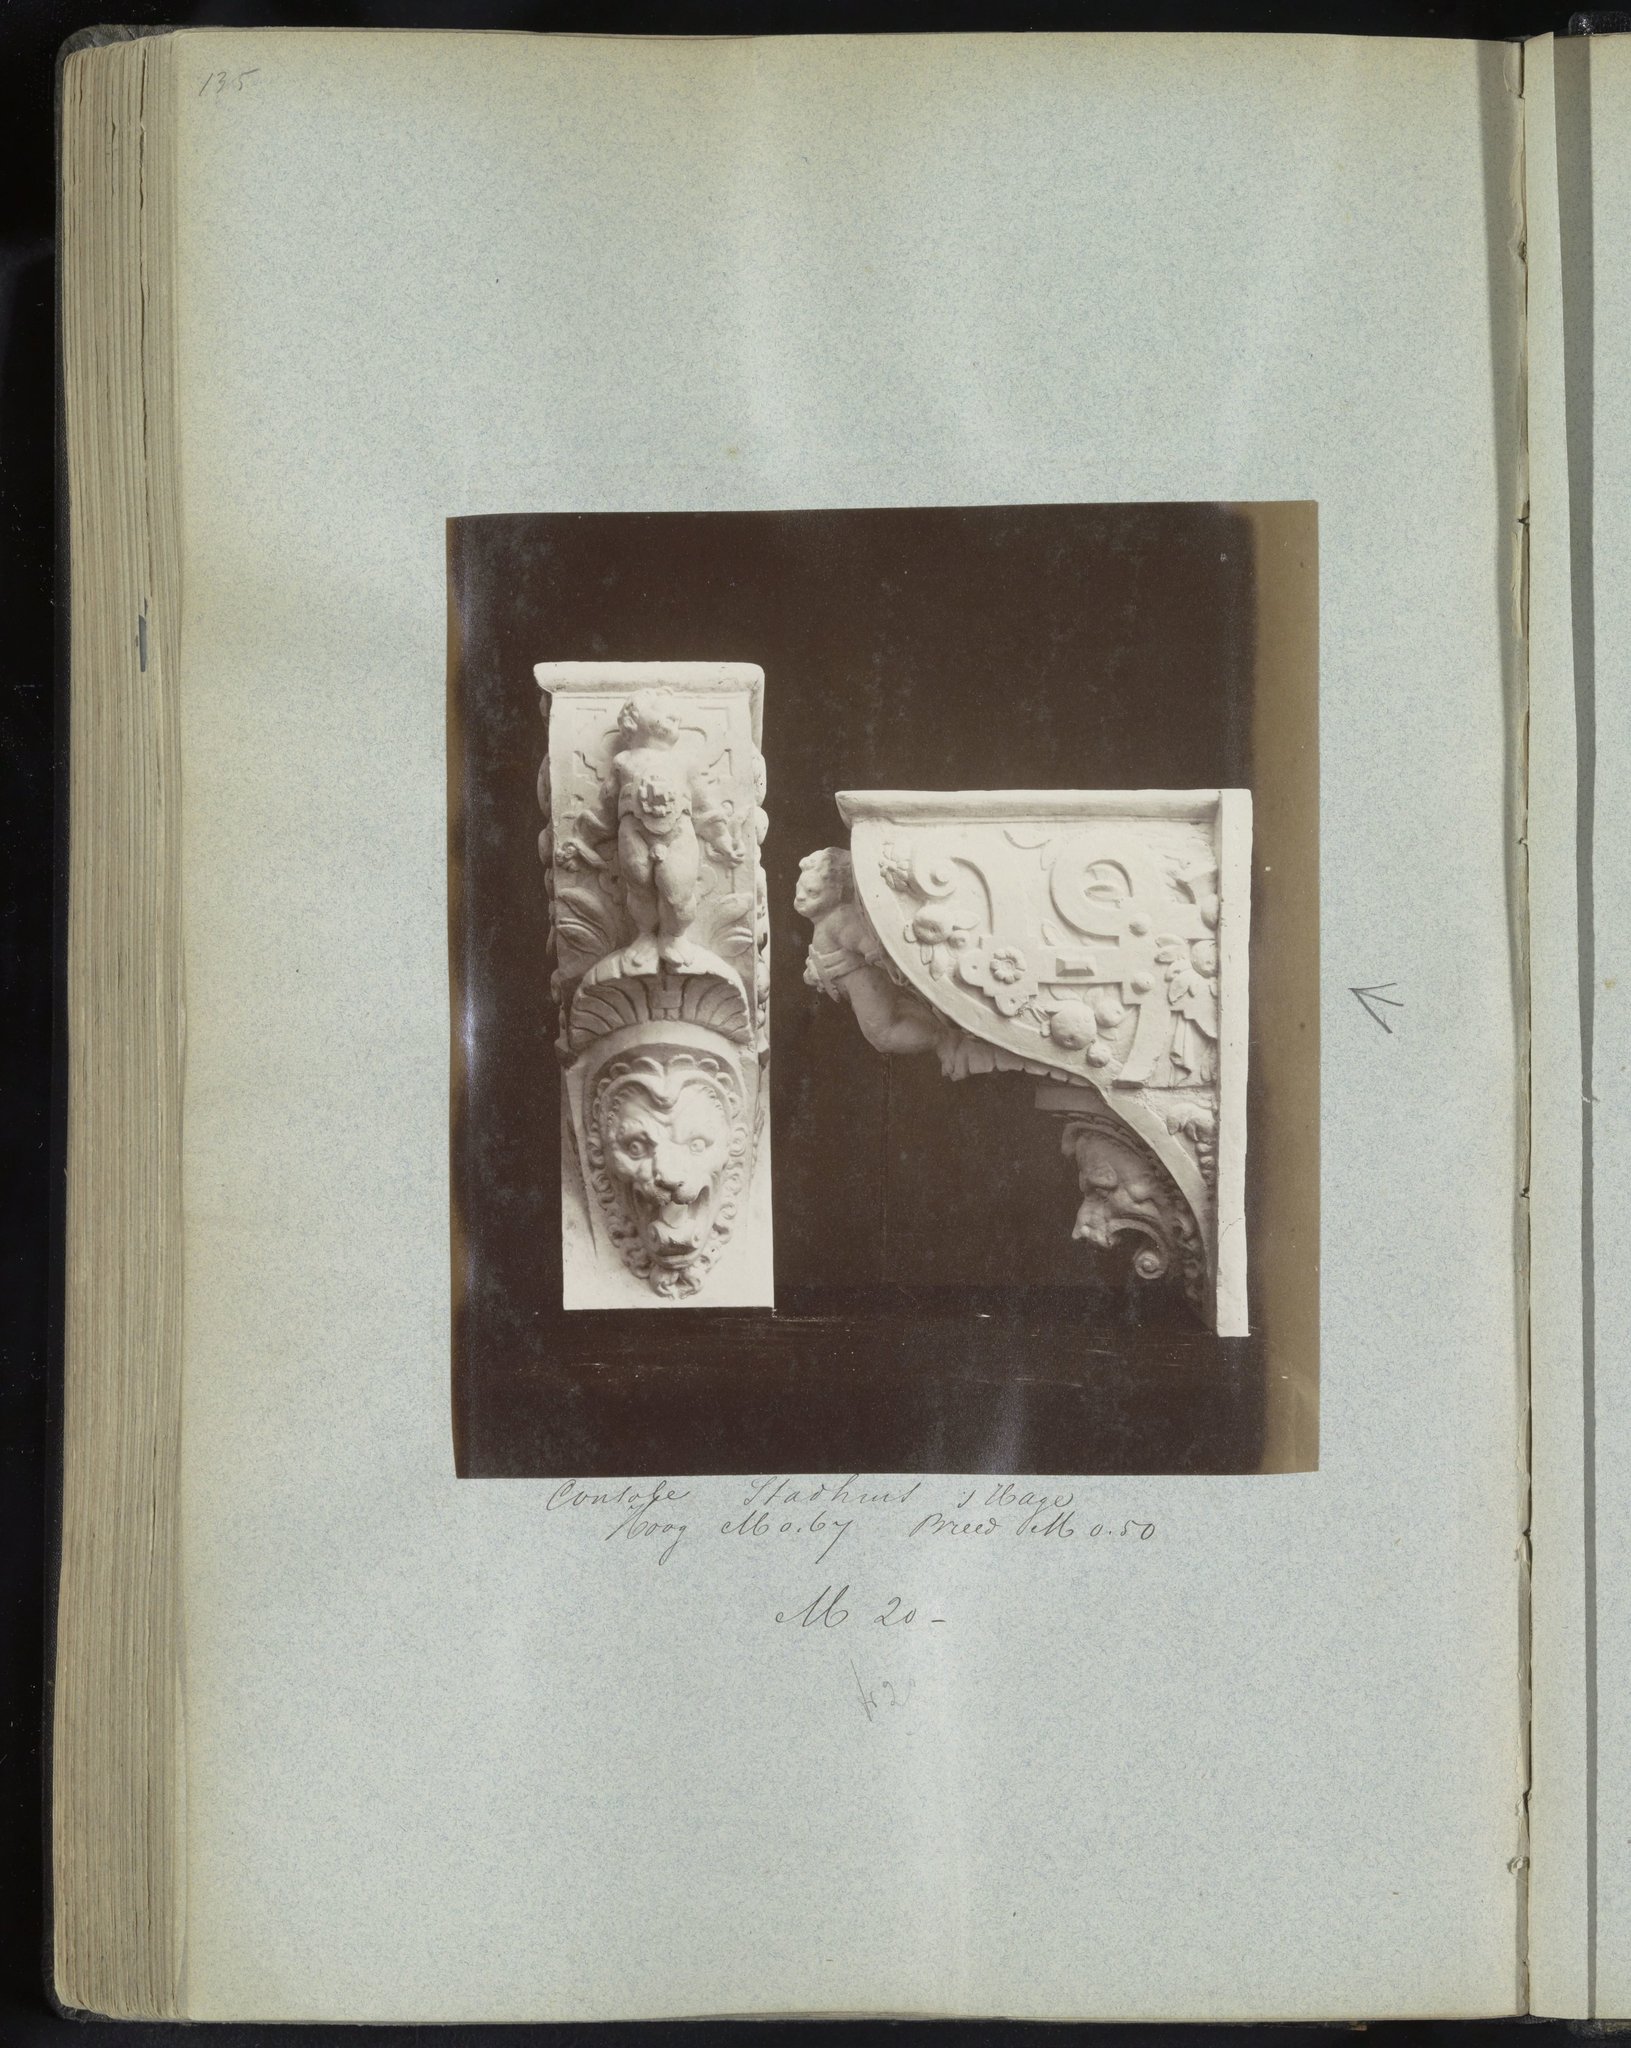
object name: photograph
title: Twee gipsen afgietsels van consoles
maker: Anonymous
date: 1875-1900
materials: paper, photographic support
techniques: albumen print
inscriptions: annotation, annotation: ‘Console [.....] / Hoog M 0.67 Breed M 0.50’